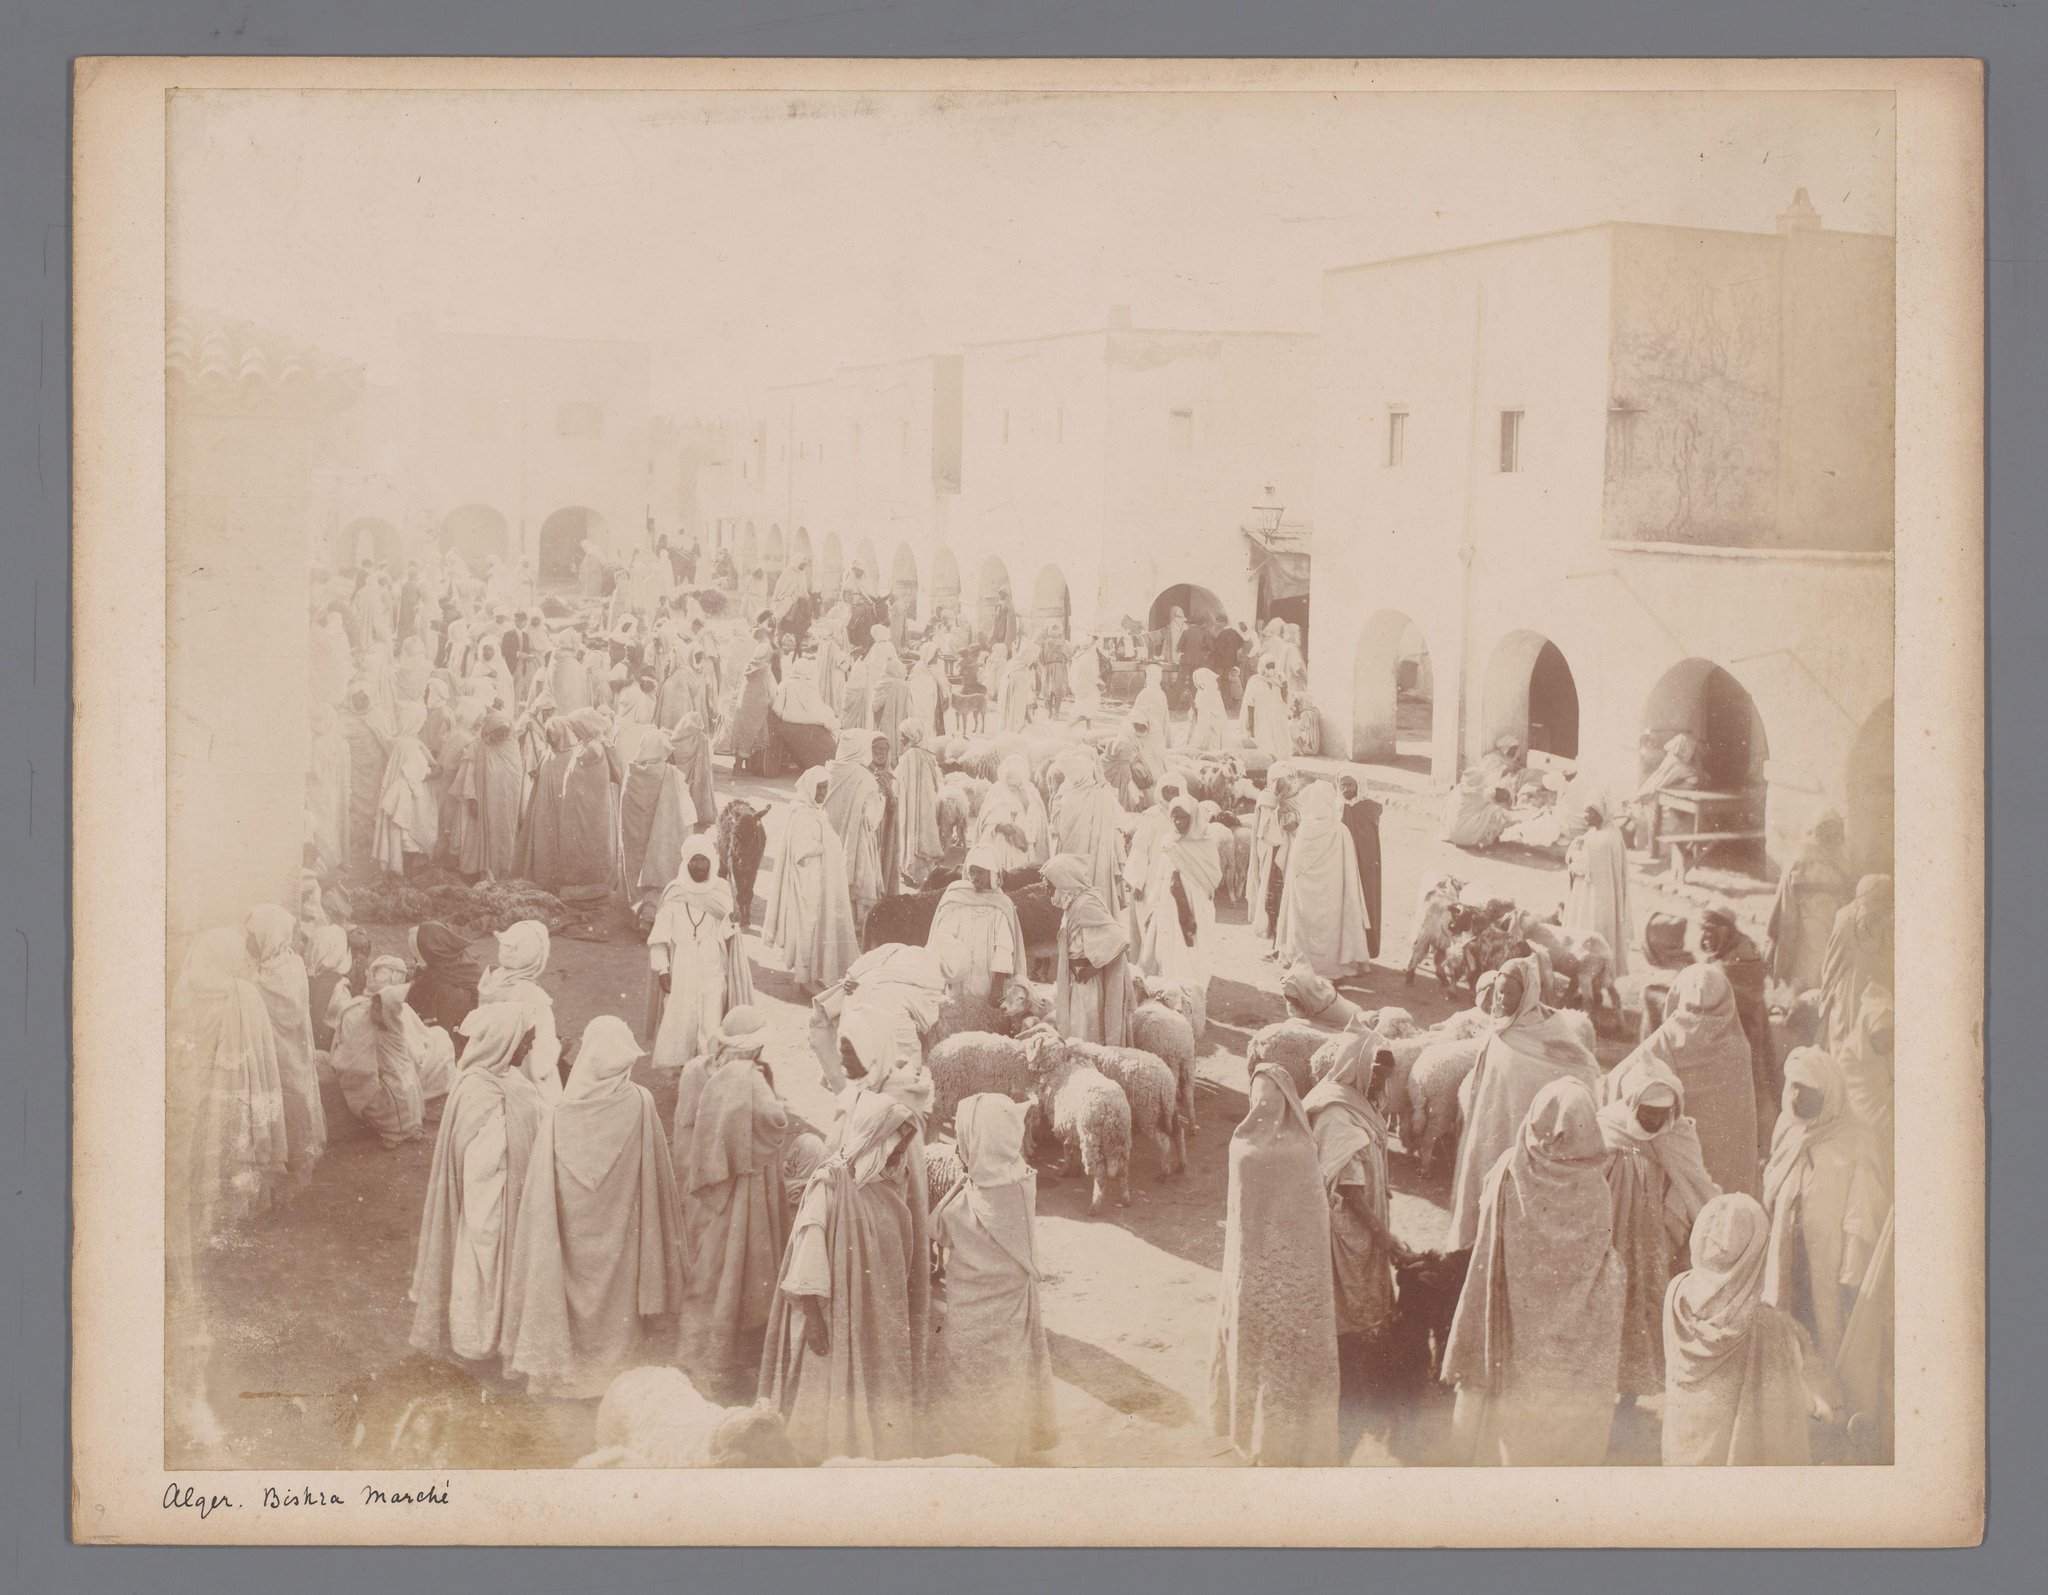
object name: photograph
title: Gezicht op een veemarkt in Biskra, Algerije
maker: Anonymous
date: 1890-1930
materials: paper, cardboard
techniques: gelatin silver print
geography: biskra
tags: market